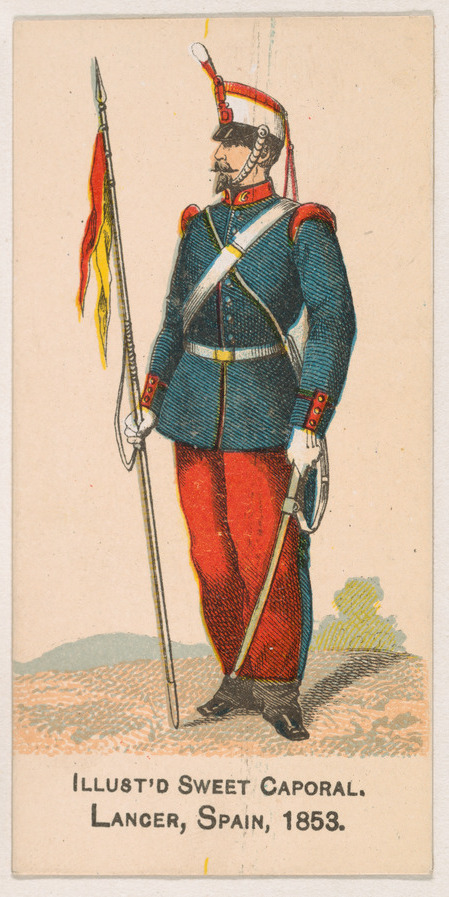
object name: print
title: Lancer, Spain, 1853, from the Military Series (N224) issued by Kinney Tobacco Company to promote Sweet Caporal Cigarettes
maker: kinney brothers tobacco company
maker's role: publisher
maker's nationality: american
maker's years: 1869-2011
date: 1888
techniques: color lithograph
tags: military,swords,men,flags